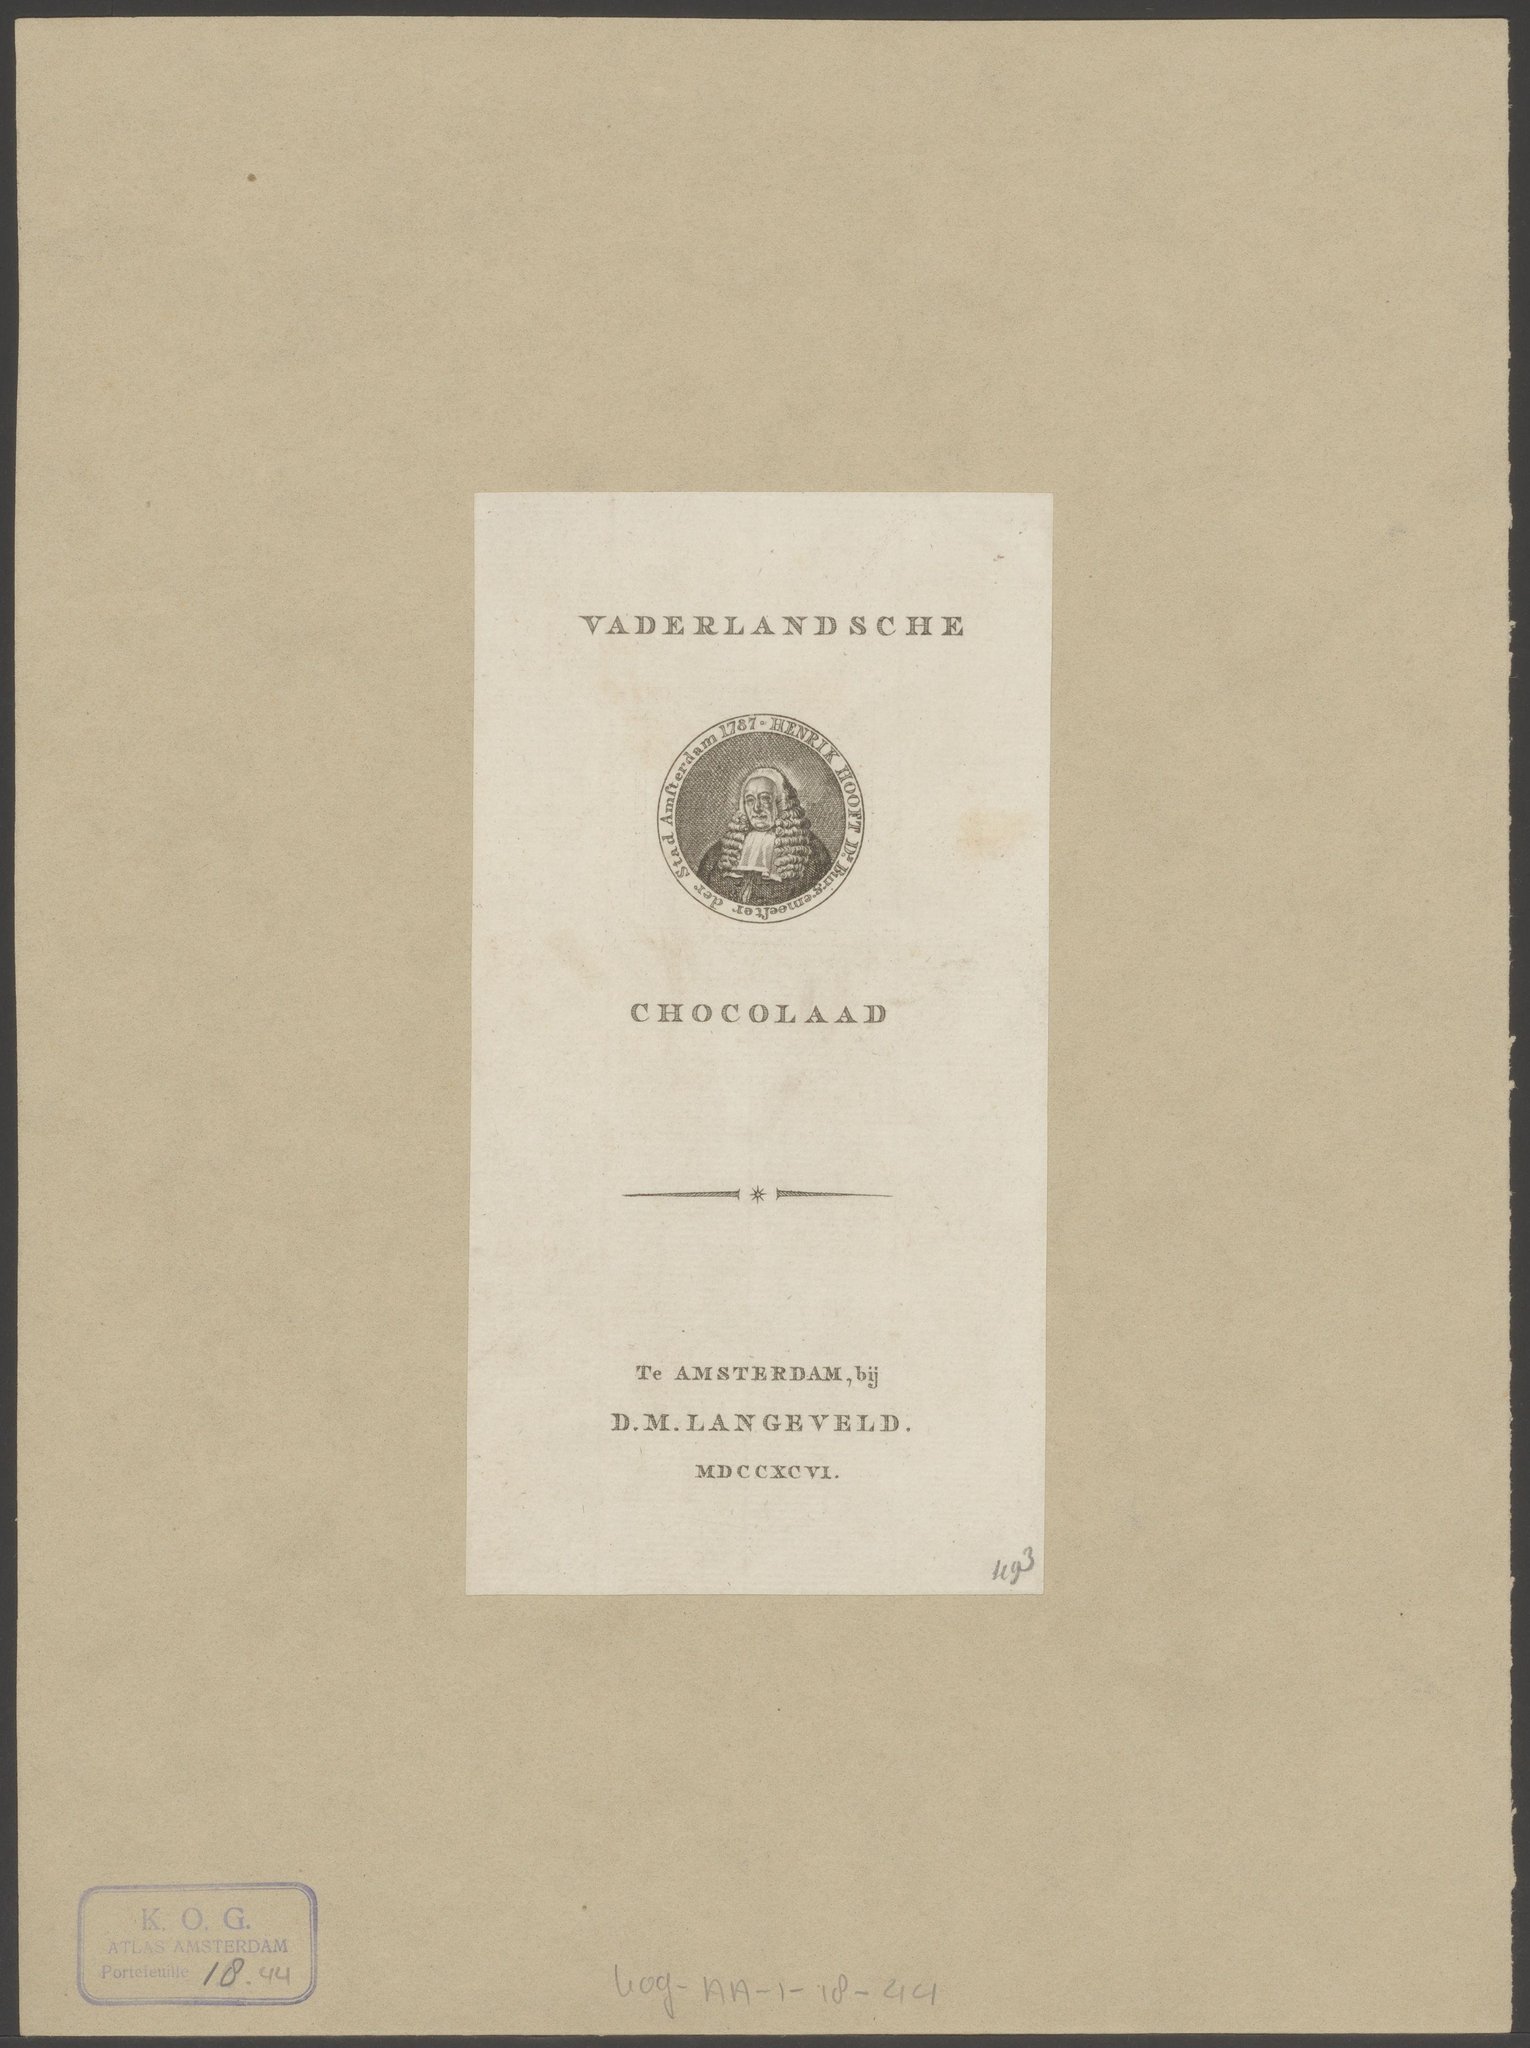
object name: titelblad, titelpagina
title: Portret van Hendrik Daniëlsz. Hooft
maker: Anonymous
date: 1796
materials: paper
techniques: etching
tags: mayor, hendrik danielsz. hooft, historical persons, patriot (revolutionary), amsterdam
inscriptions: collector's mark: ‘18.44’ Lugt 1641b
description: Onderwerpsrubriek binnen de Atlas Amsterdam: Herinneringen aan regeringsleden en hunne huisgezinnen [voor 1800].